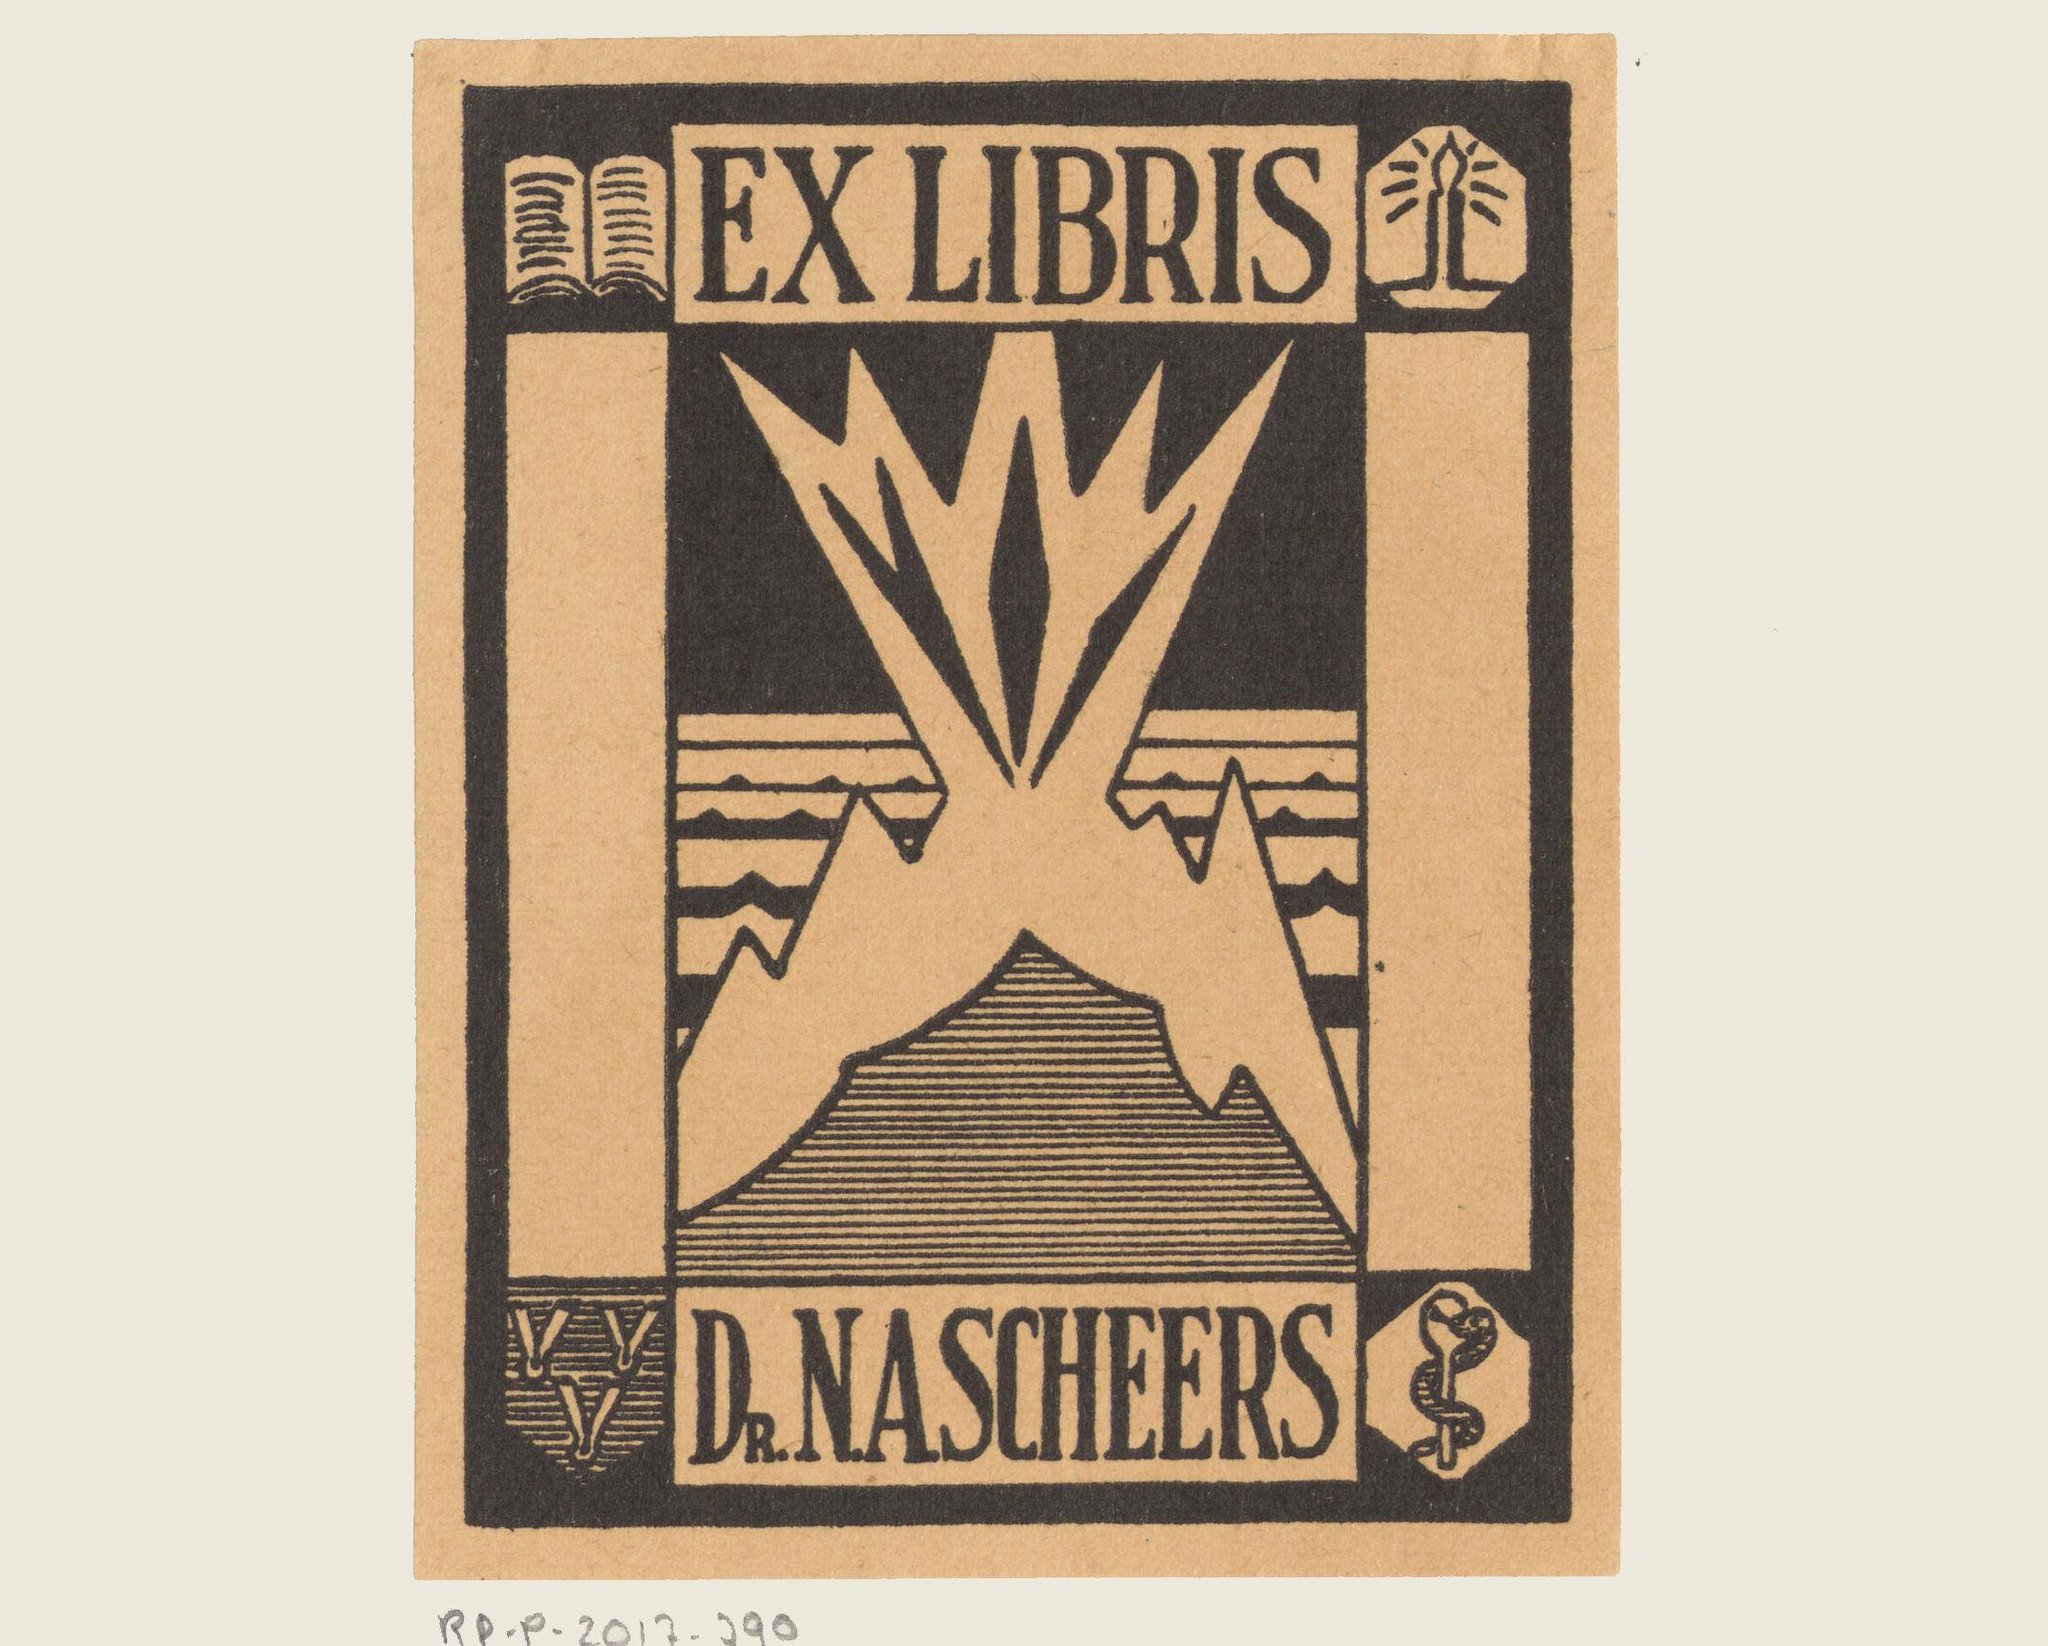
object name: bookplate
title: Ex libris van N.A. Scheers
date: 1930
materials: paper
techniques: printing block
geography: netherlands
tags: n.a. scheers, book, candle, aesculapian sign, eruption (of volcano), armorial bearing, heraldry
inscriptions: signature and date: ‘ipse fecit 1930’